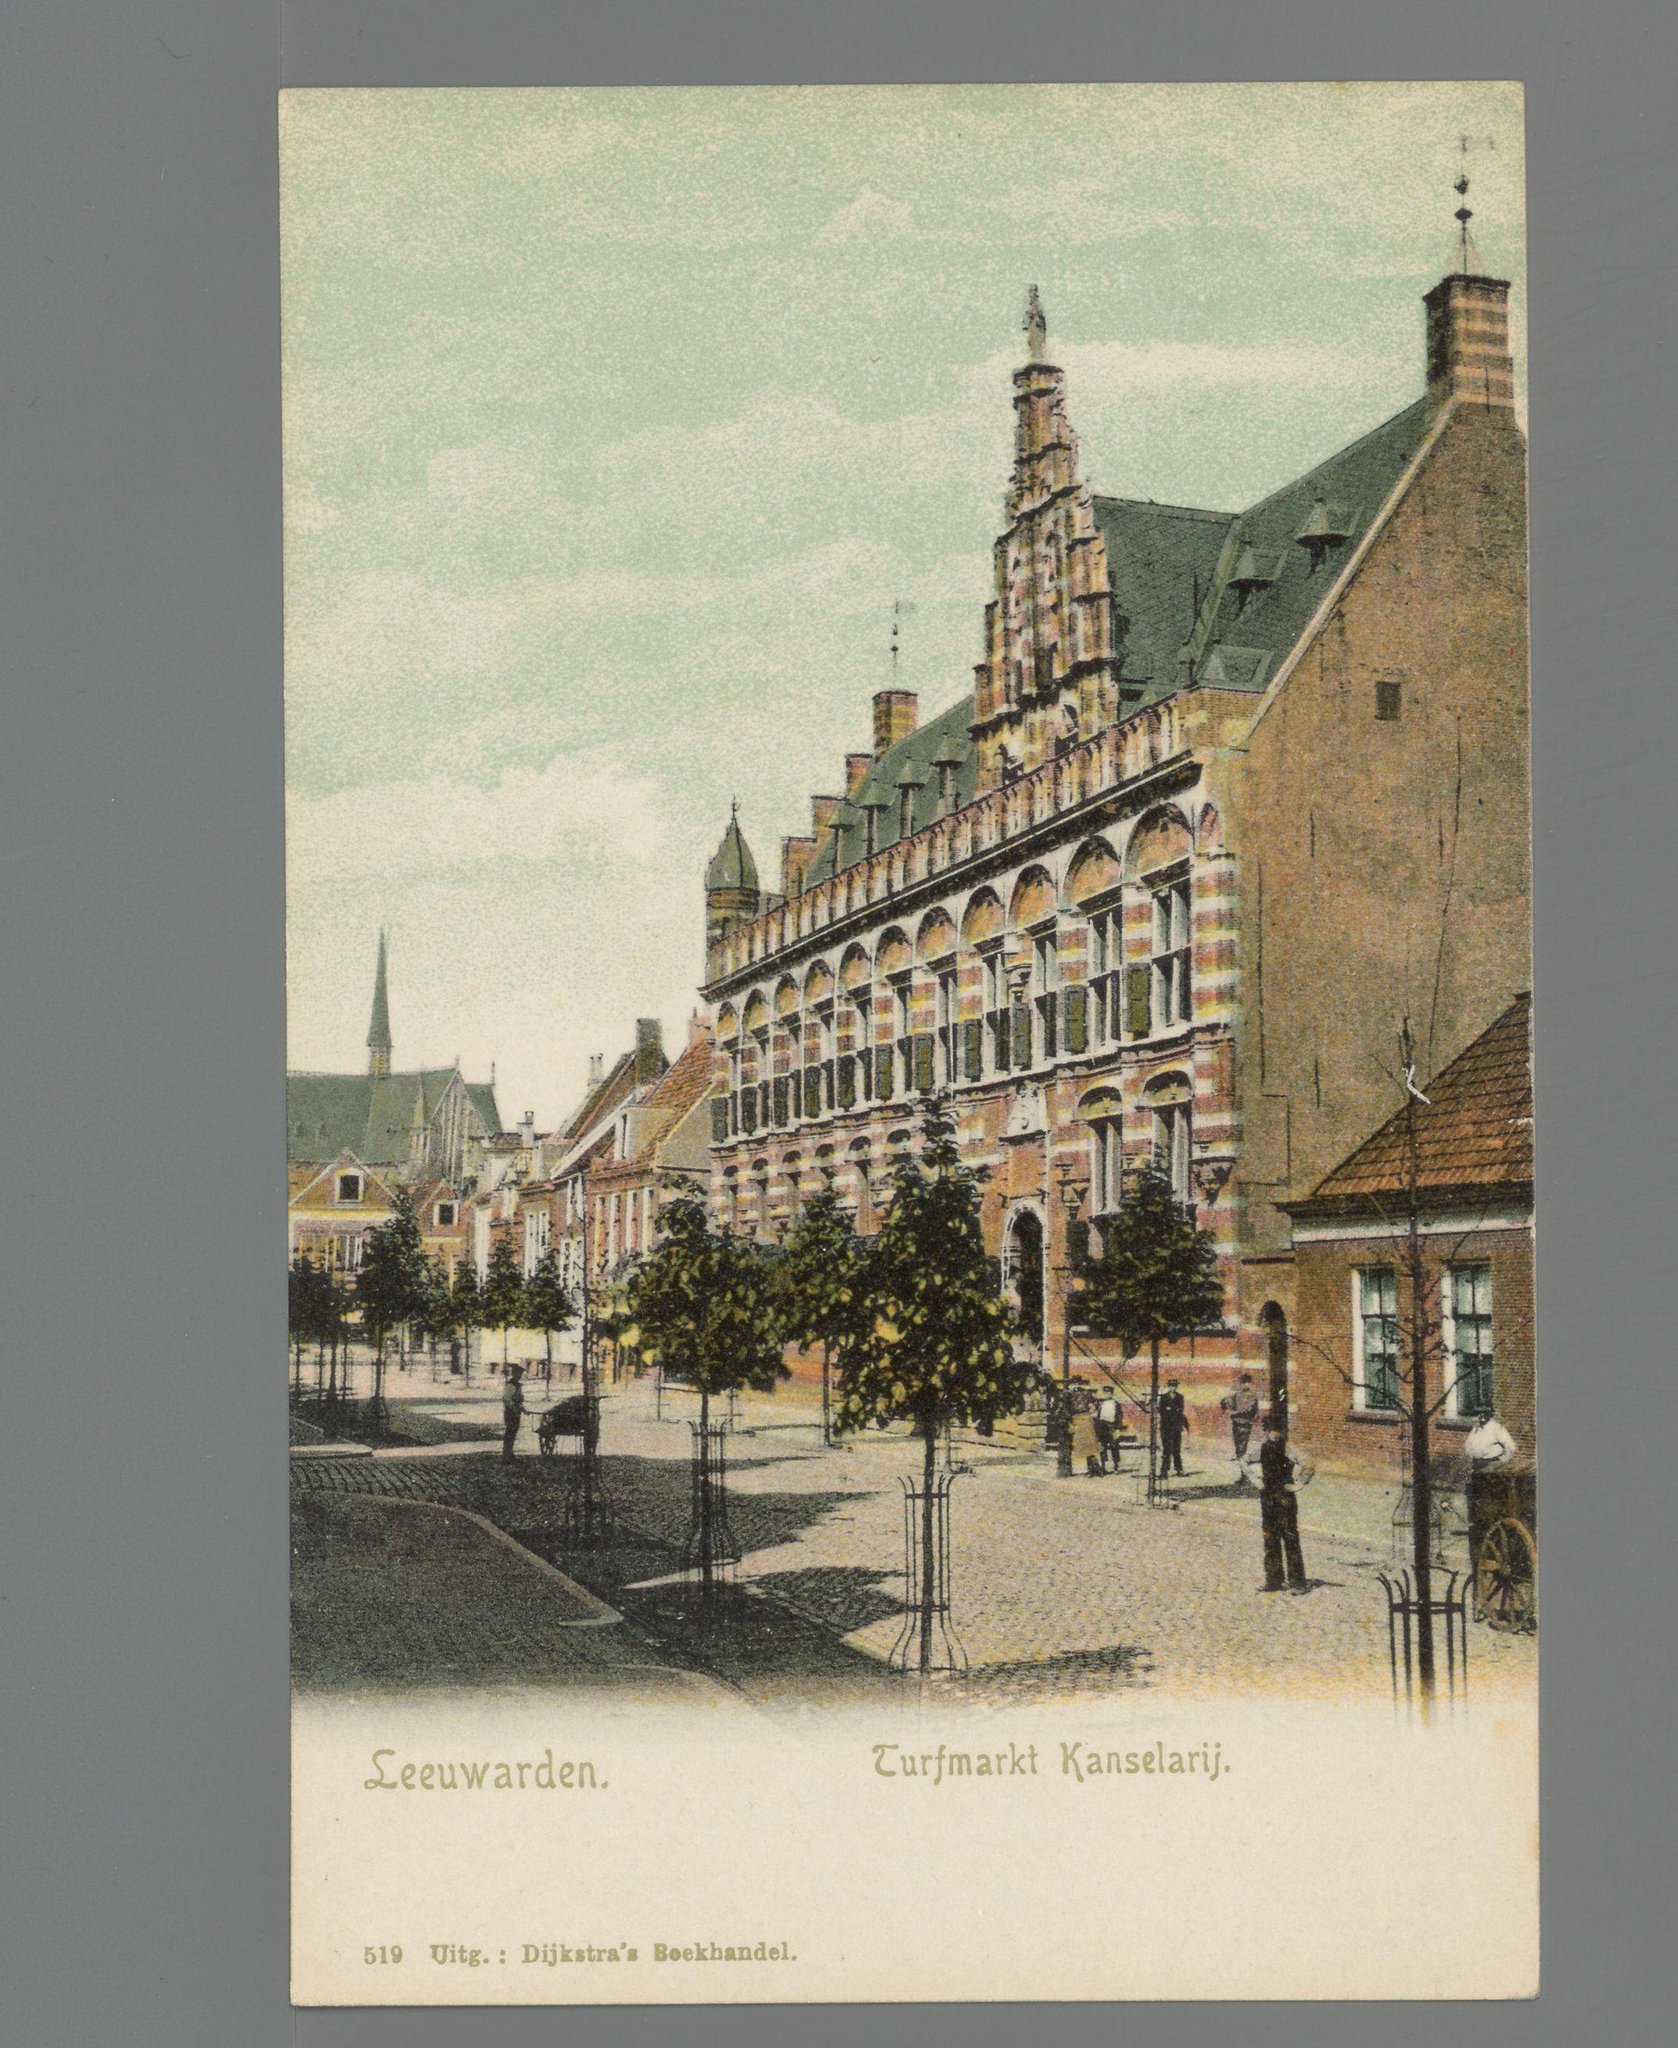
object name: photomechanical print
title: Leeuwarden. Turfmarkt Kanselarij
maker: Anonymous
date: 1897-1905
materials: cardboard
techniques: photograph, lithograph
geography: leeuwarden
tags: façade (of house or building), street